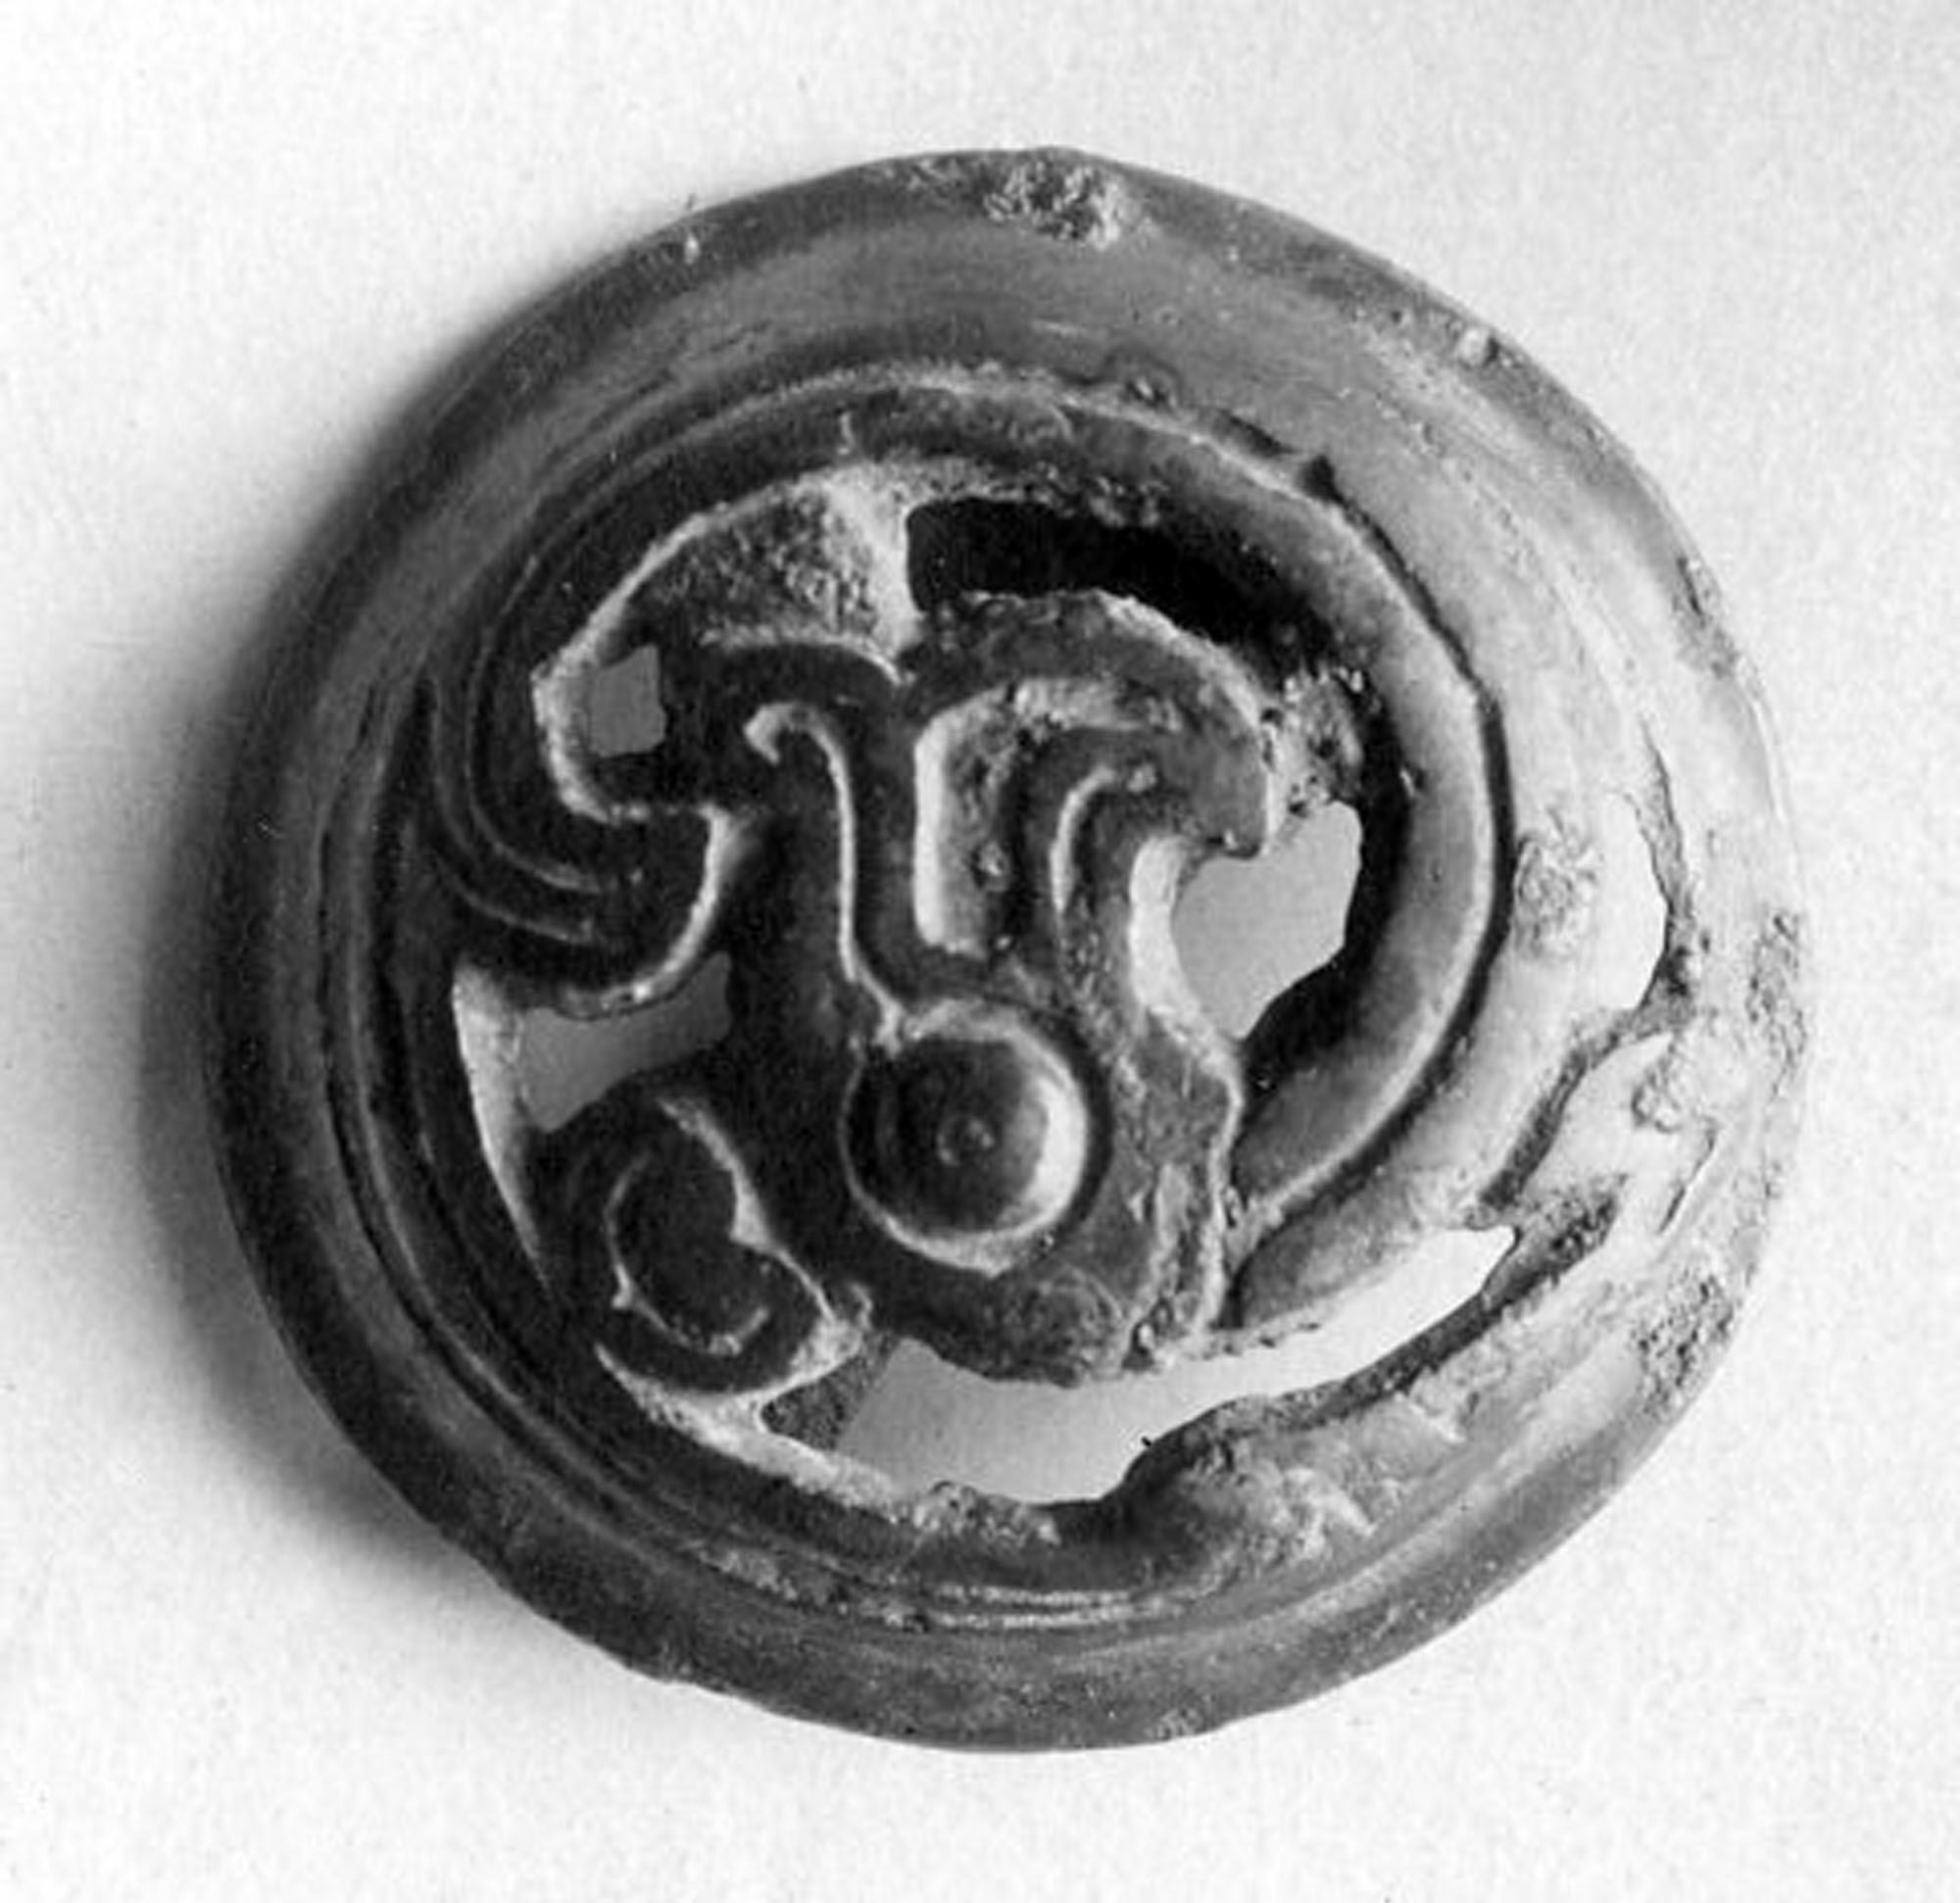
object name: belt ornament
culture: chinese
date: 206 BCE-220 CE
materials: bronze